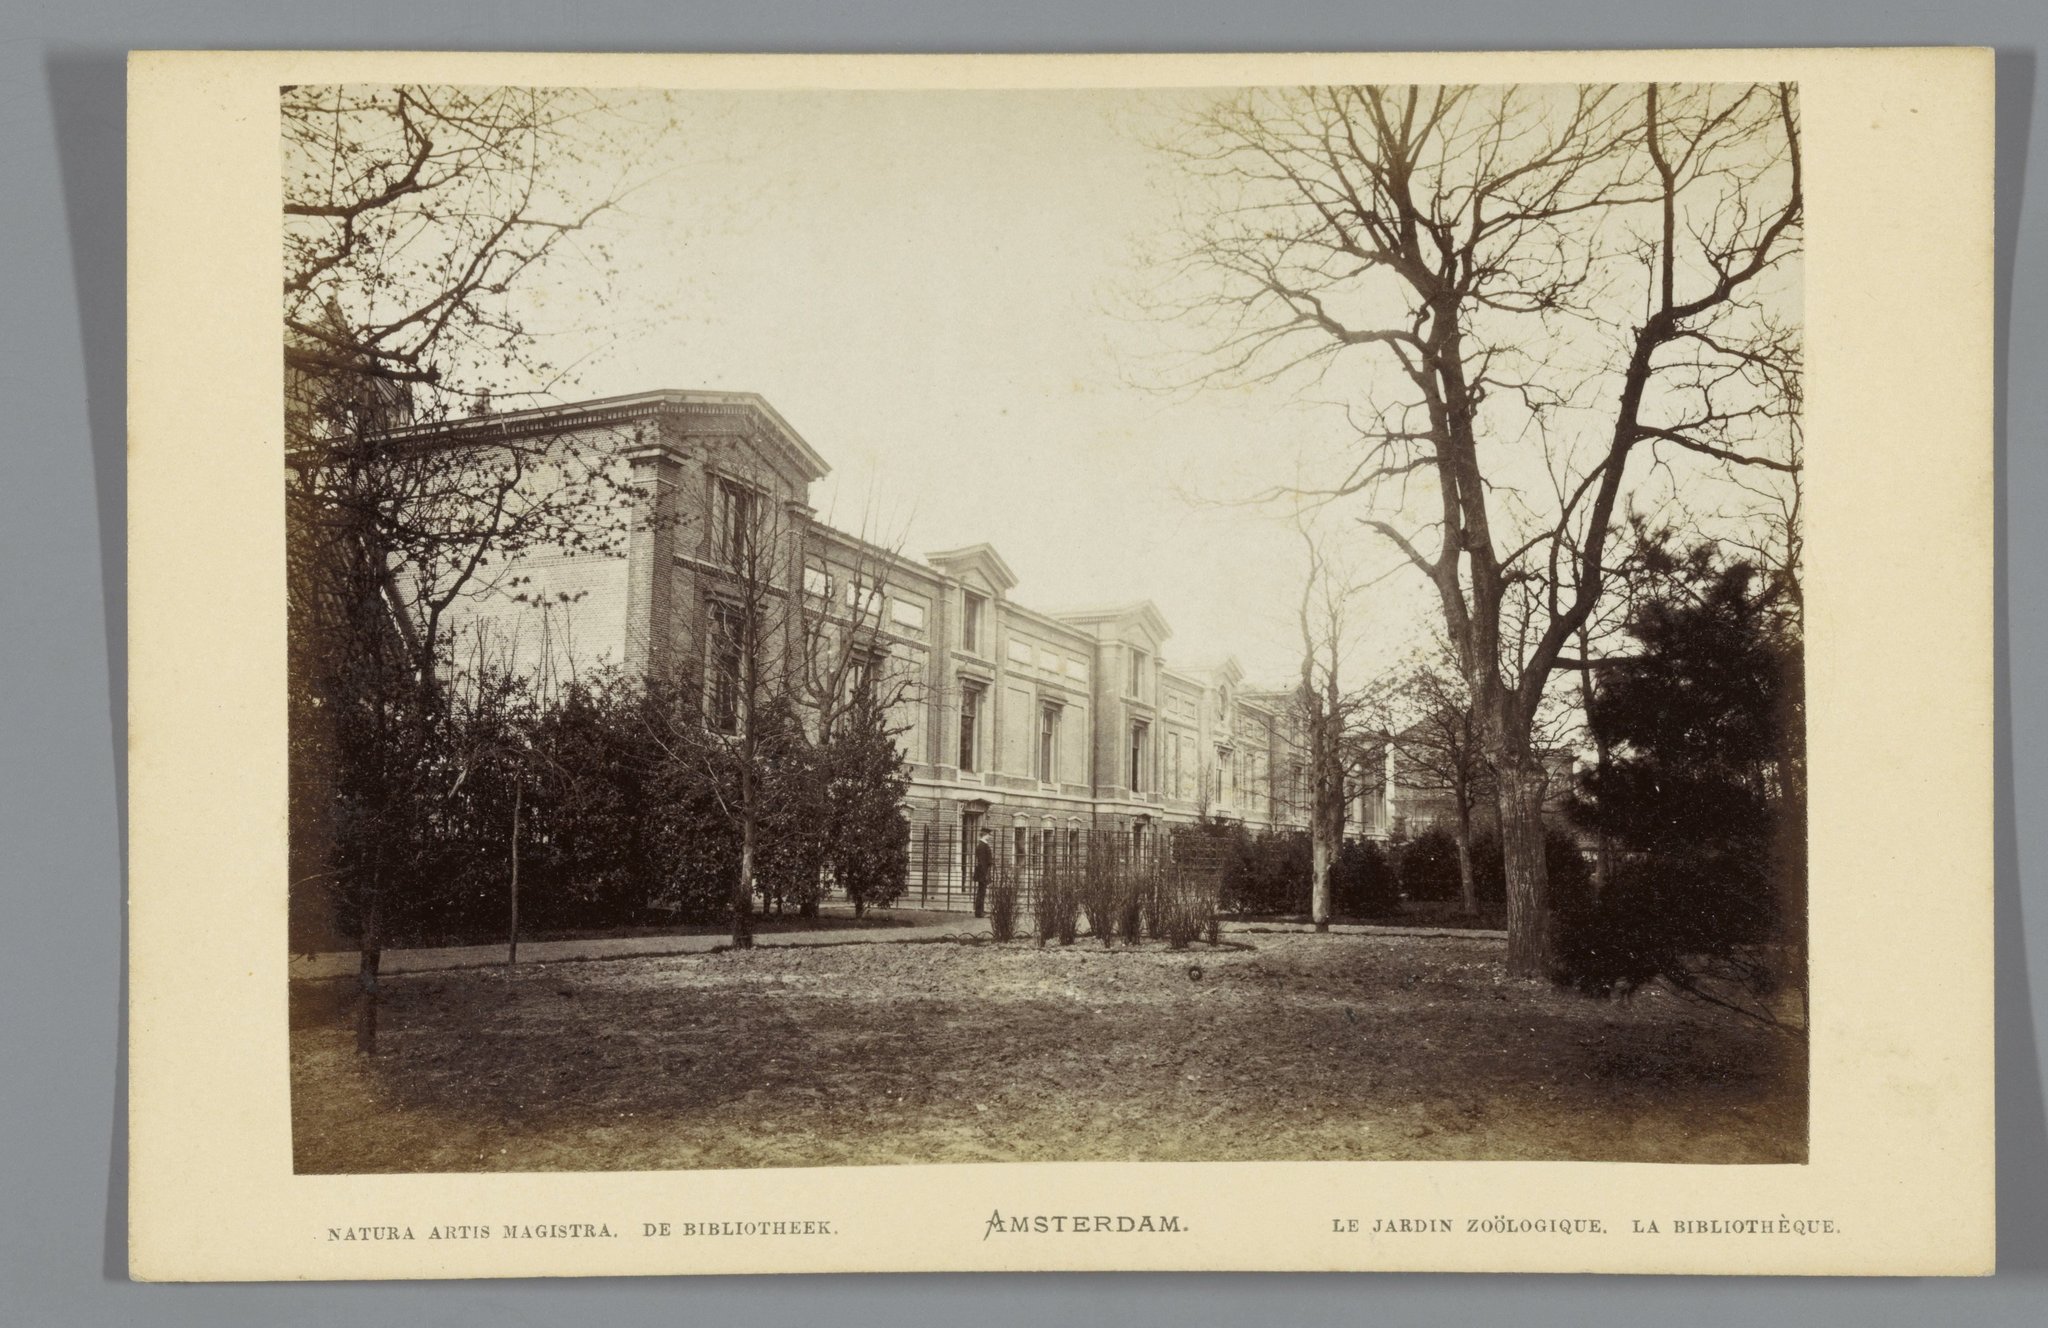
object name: cabinet photograph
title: Natura Artis Magistra. De bibliotheek / Le jardin zoölogique. La bibliothèque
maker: andries jager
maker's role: publisher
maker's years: 1825-1905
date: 1860-1890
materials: cardboard, photographic support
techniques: albumen print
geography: amsterdam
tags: study; 'studiolo'; library, zoological garden, zoo, seen as place where non-domestic animals are kept